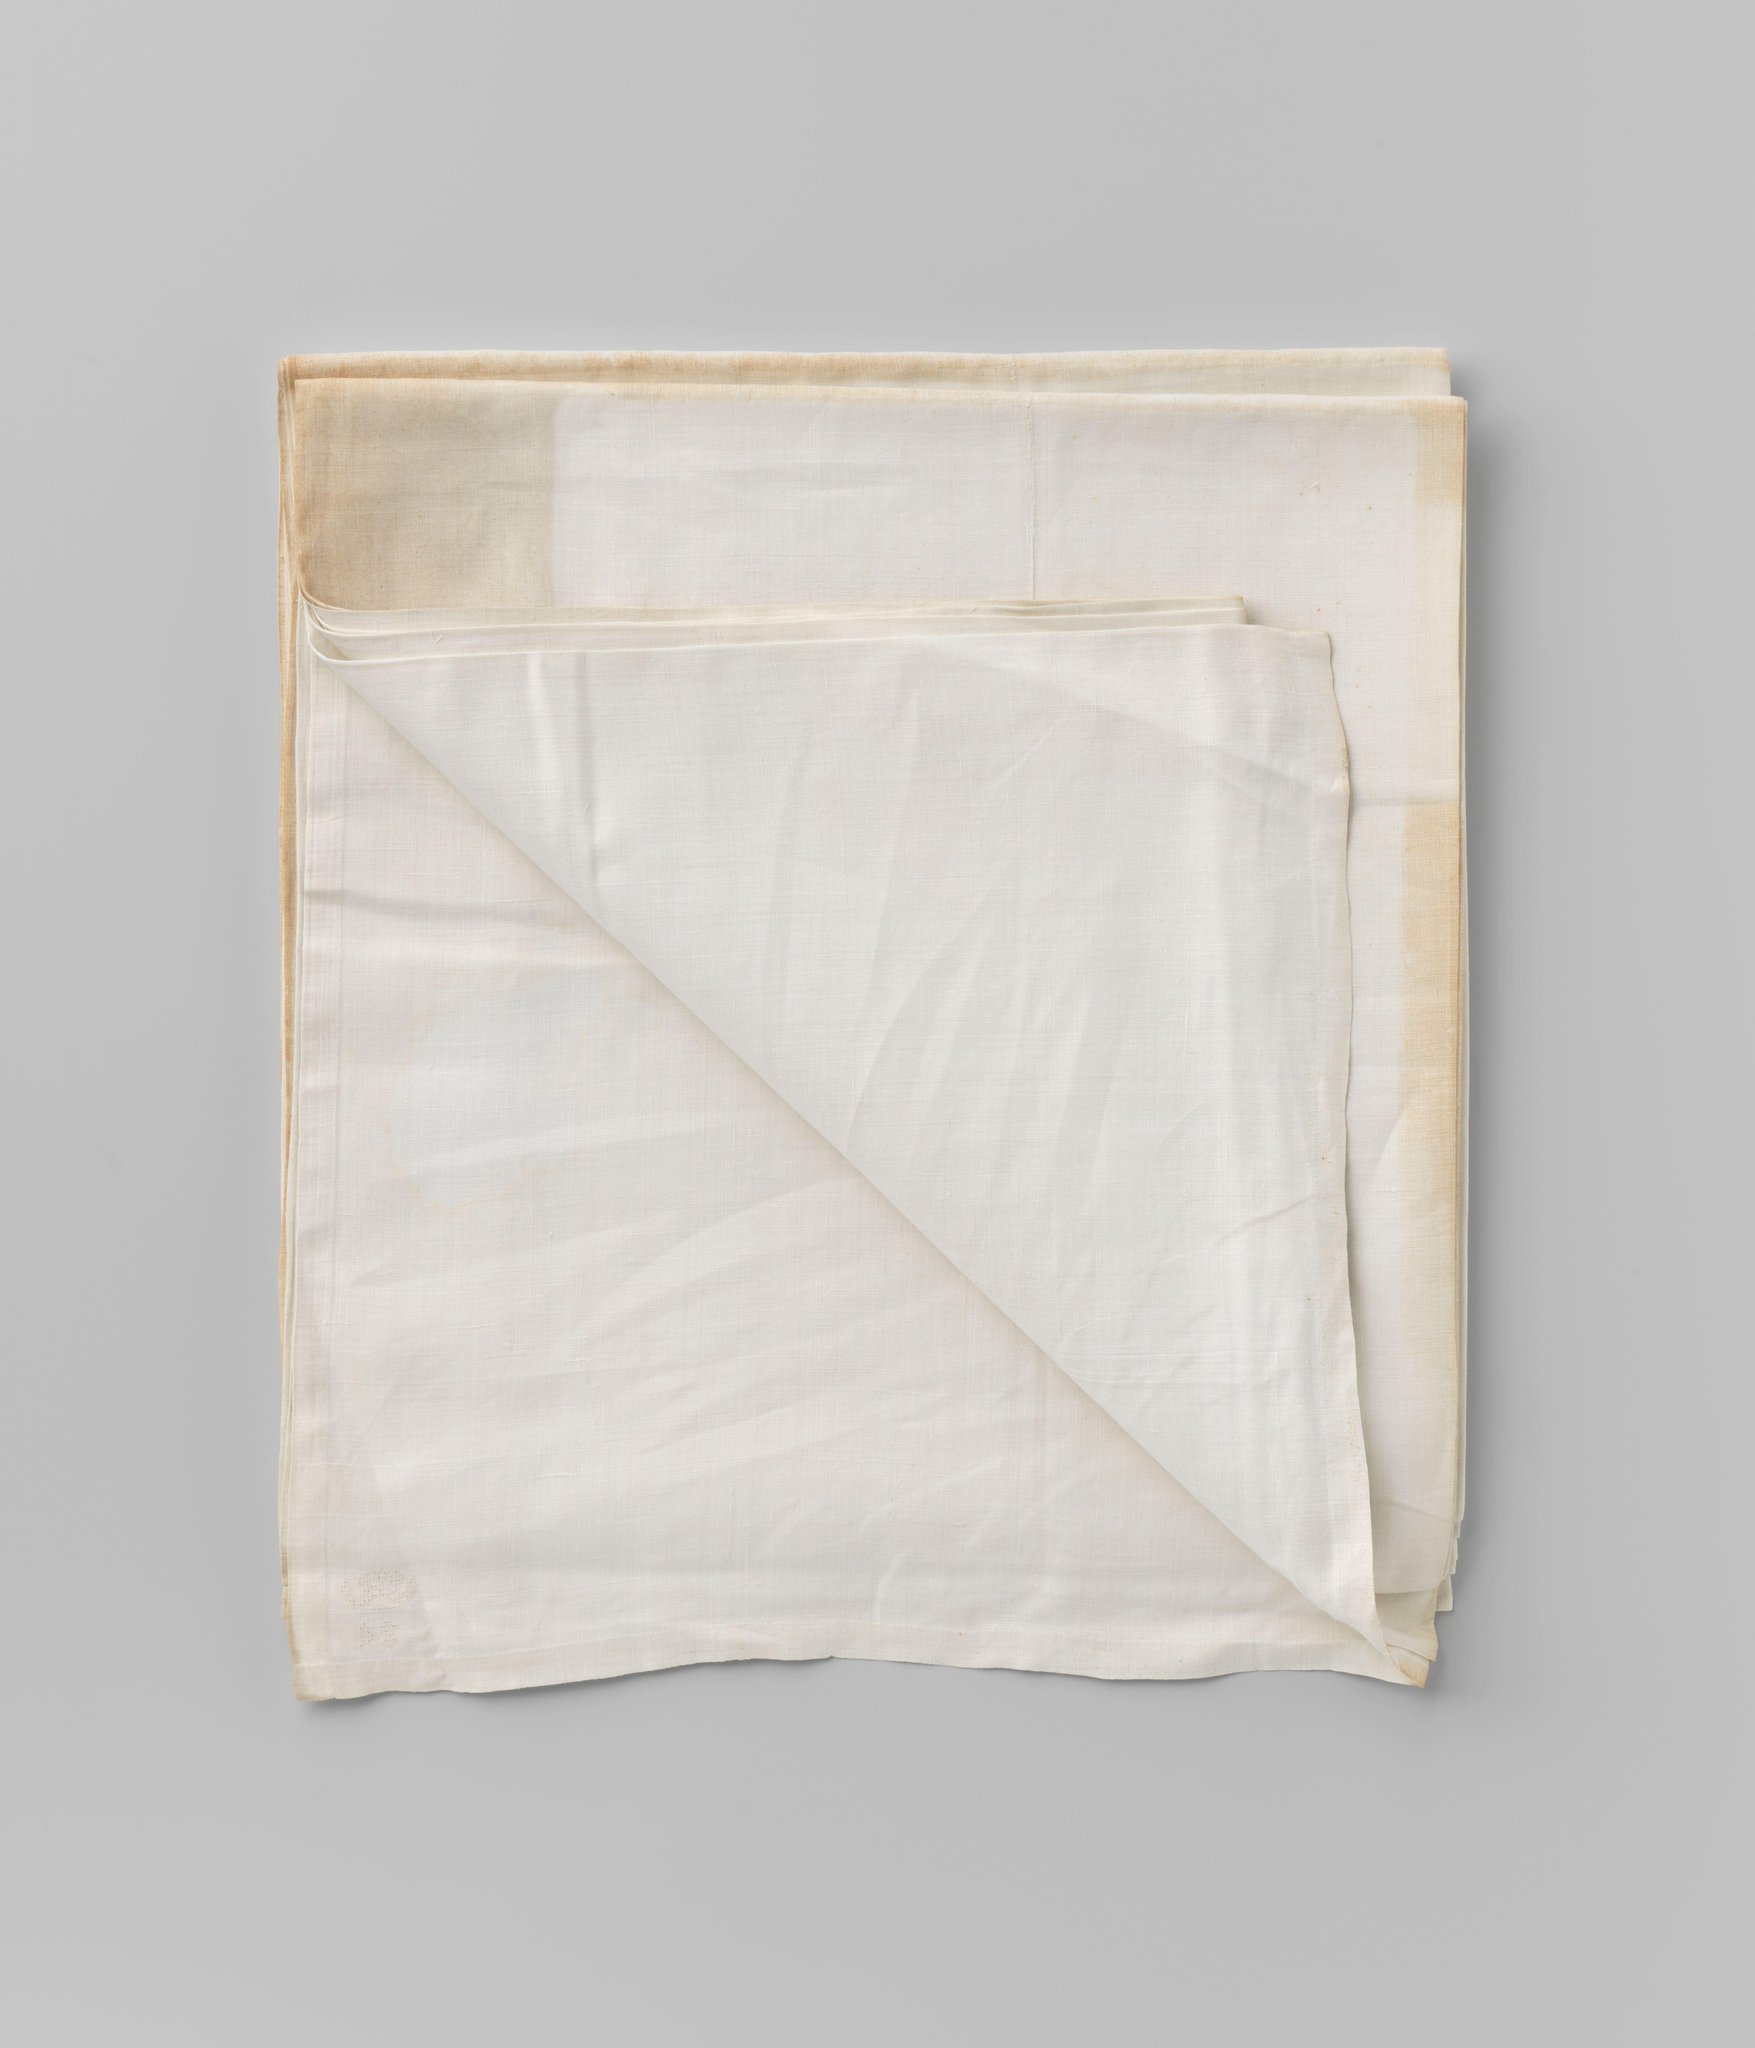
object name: beddenlaken, laken object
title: Laken. Merk: kroon GS.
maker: Anonymous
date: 1692-1735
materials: linen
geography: northern netherlands